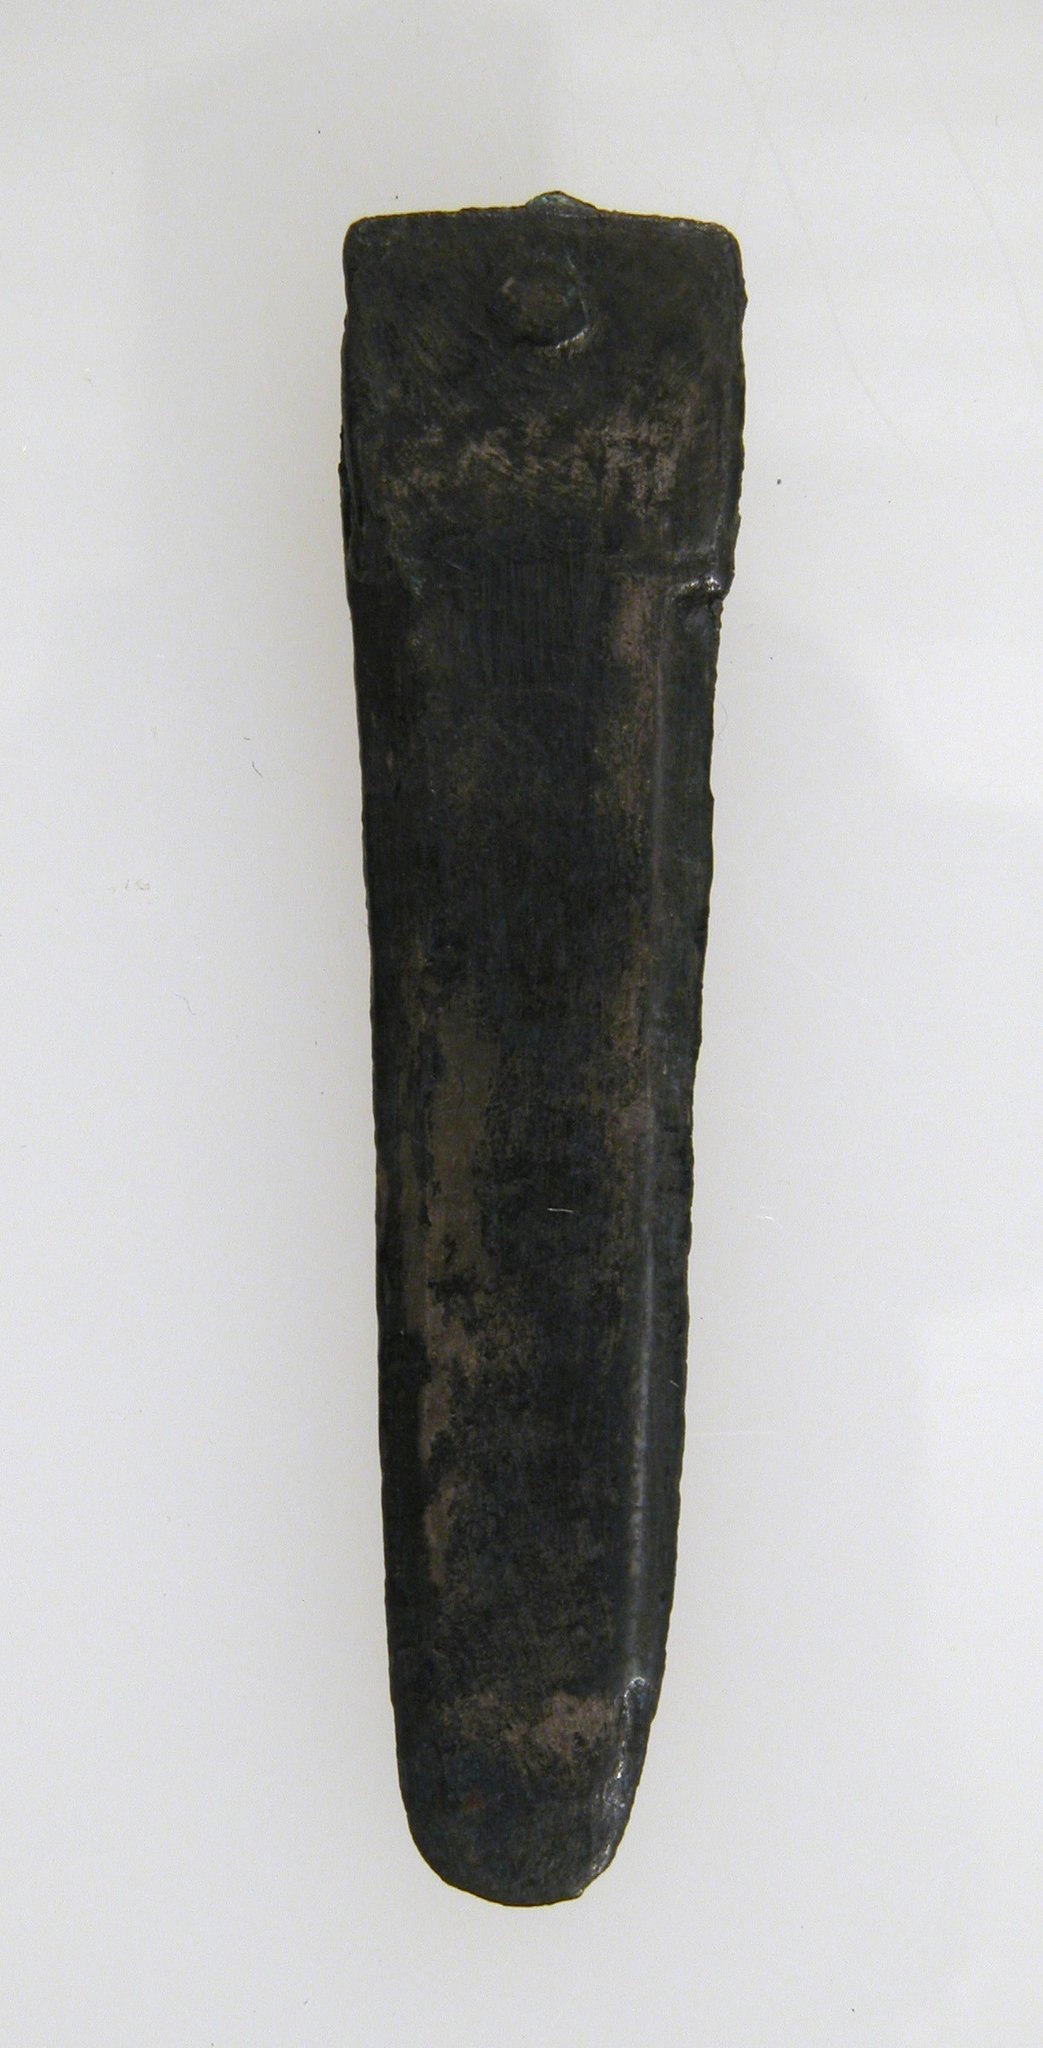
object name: ferret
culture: frankish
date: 501-700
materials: silver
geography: northern france